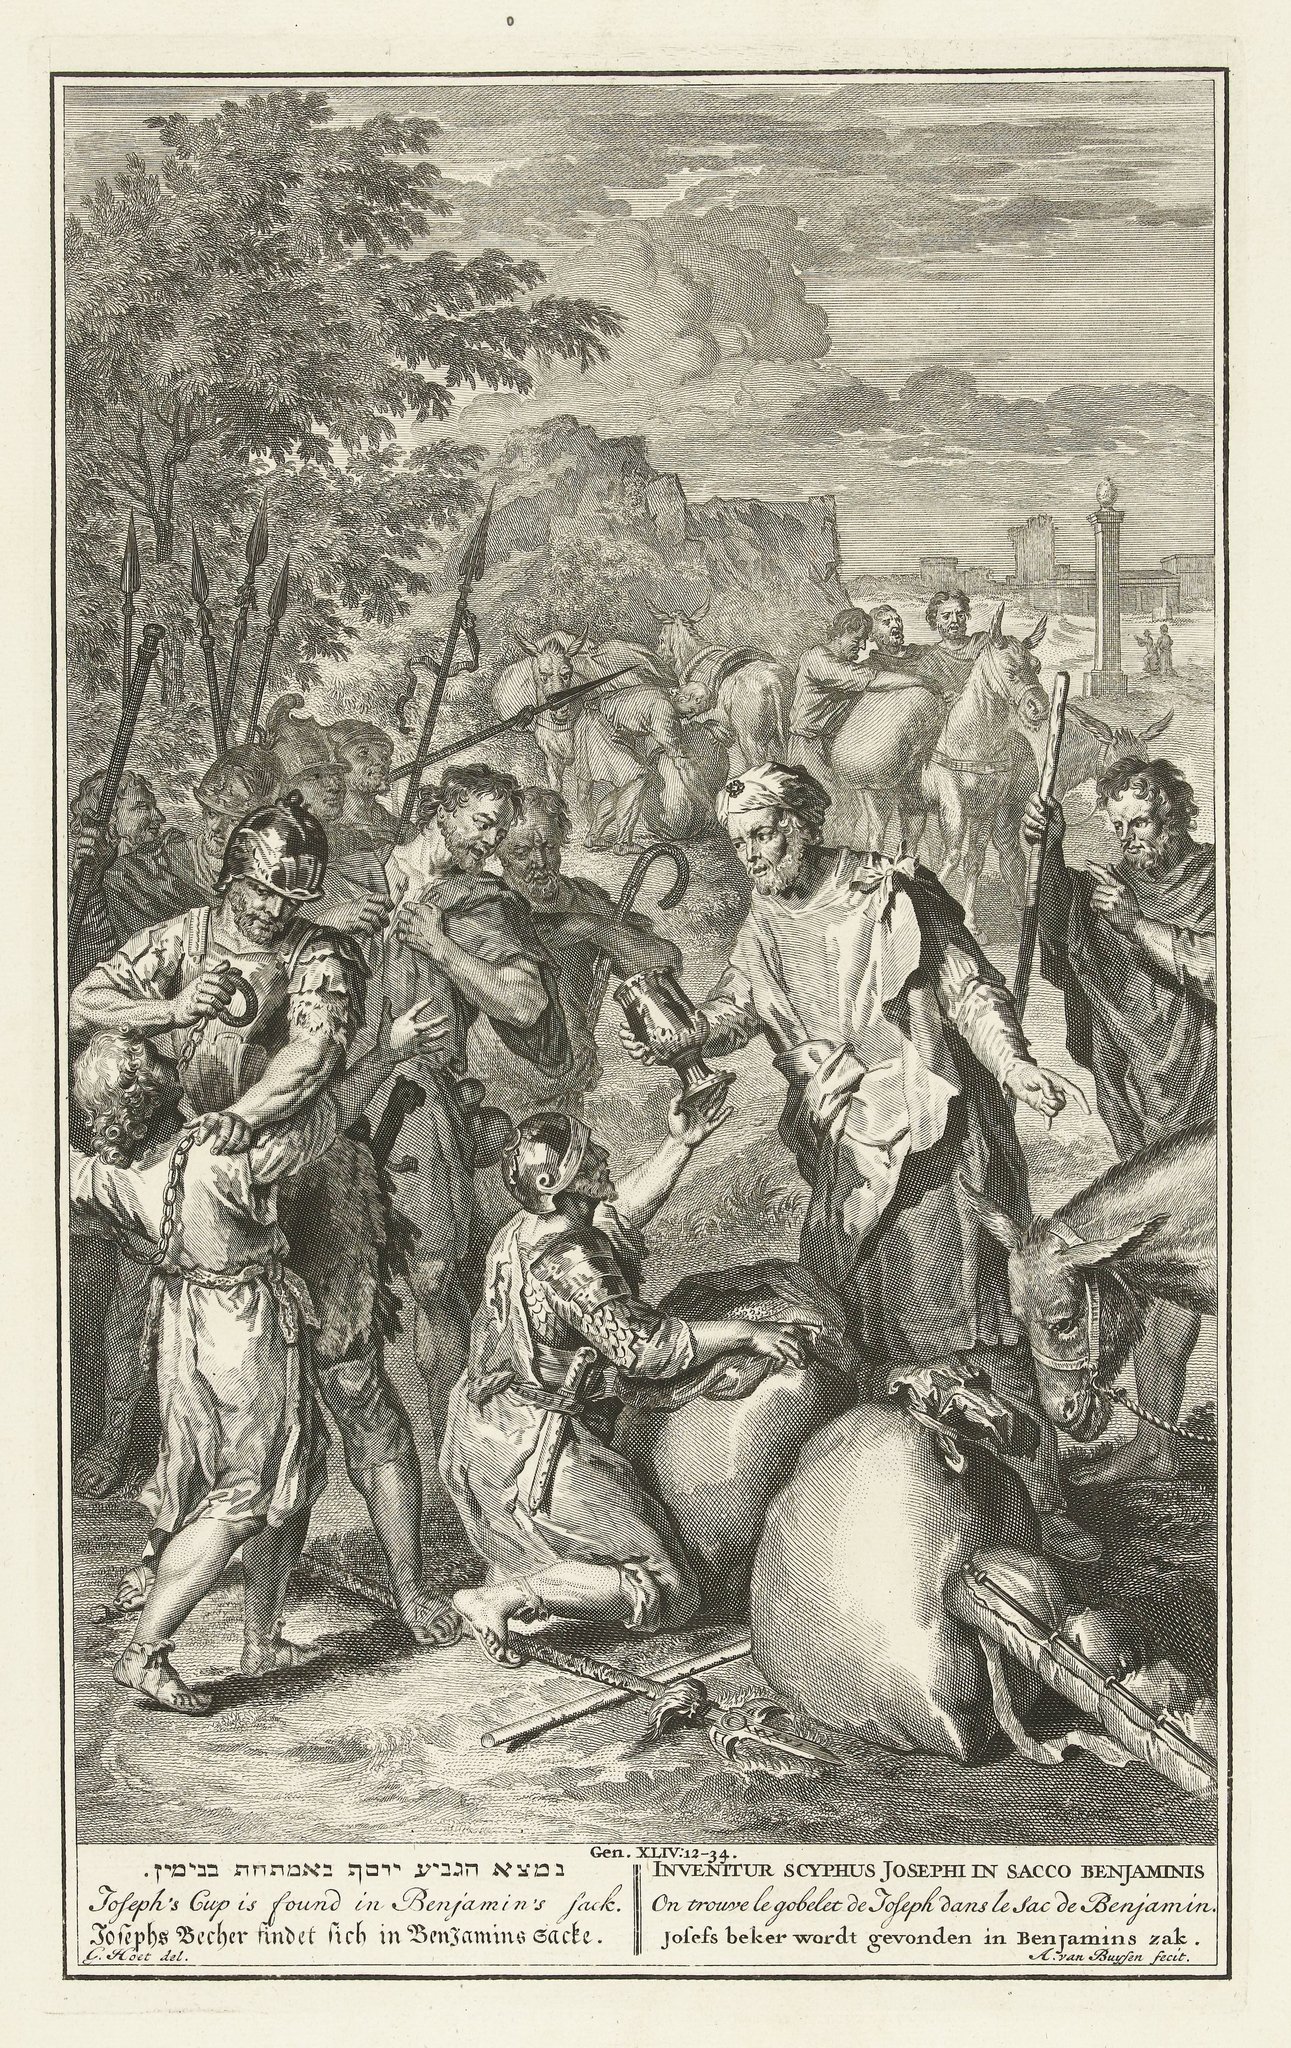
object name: print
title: Jozefs beker wordt gevonden in Benjamins zak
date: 1711-1720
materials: paper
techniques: engraving, etching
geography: amsterdam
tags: the cup is found in benjamin's sack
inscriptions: collector's mark: ‘Utrechts fundatie huys’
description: In opdracht van Jozef doorzoeken zijn mannen de bagage van zijn broers. In de zak van zijn jongste broer Benjamin vinden zij een gouden beker. Benjamin wordt gevangen genomen en terug gebracht naar Jozef. Illustratie voor het Oude Testament, Gen. 44: 12-34. Onder de voorstelling een titel in het Hebreeuws, Engels, Duits, Latijn, Frans en Nederlands.